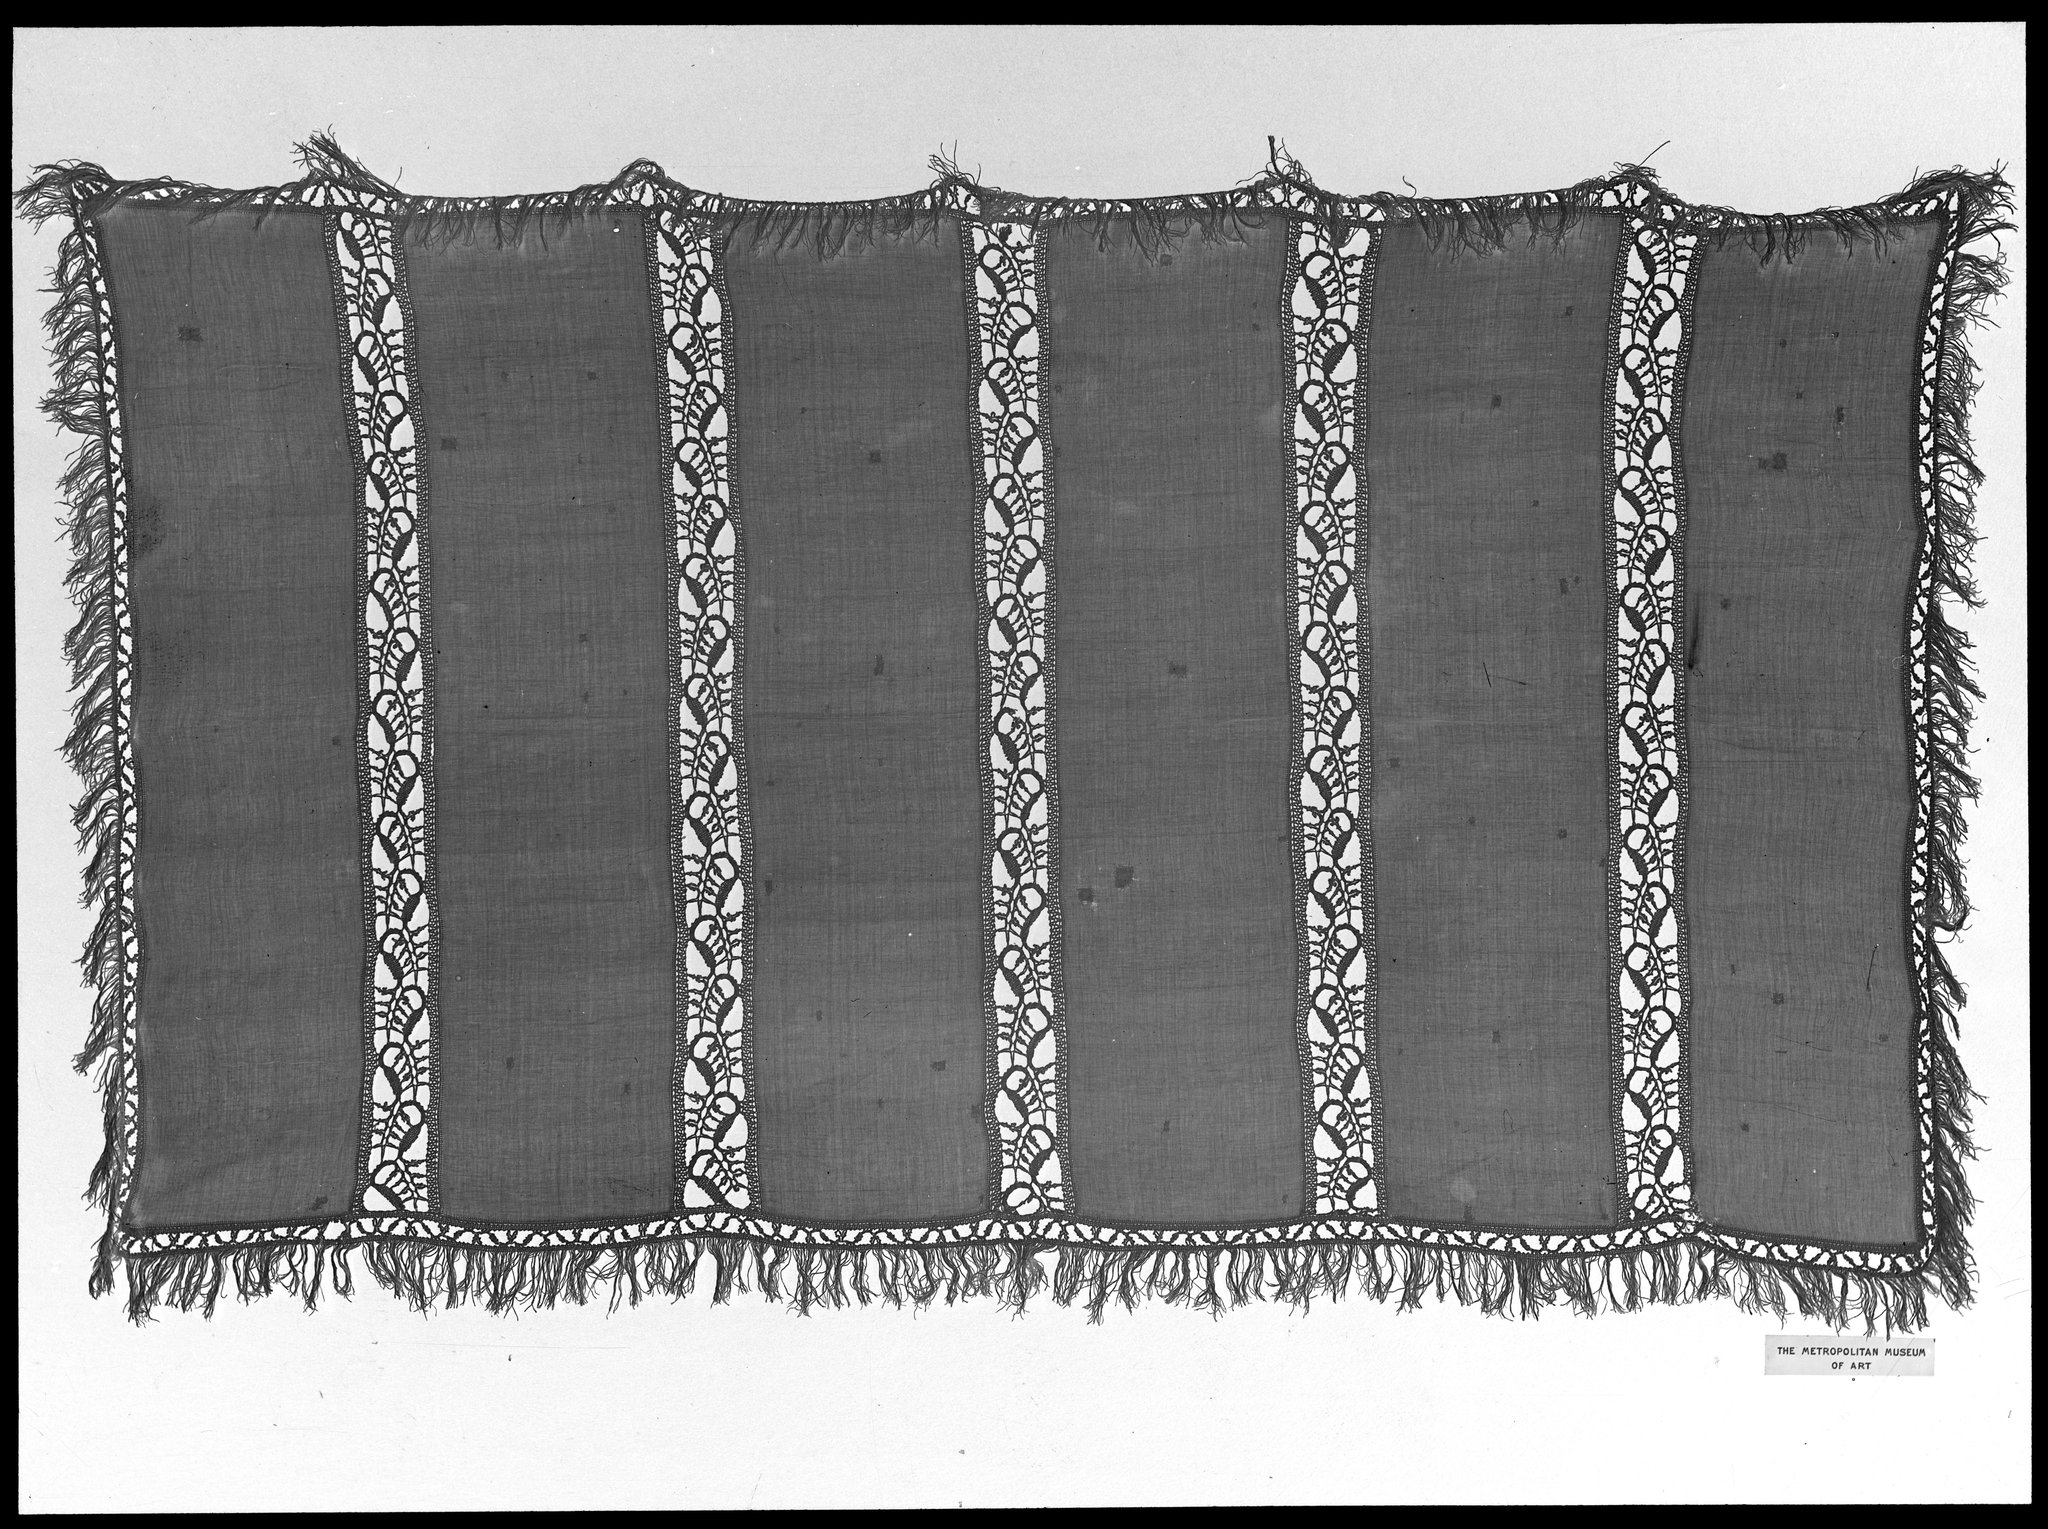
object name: cover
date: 1601-1633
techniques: lace